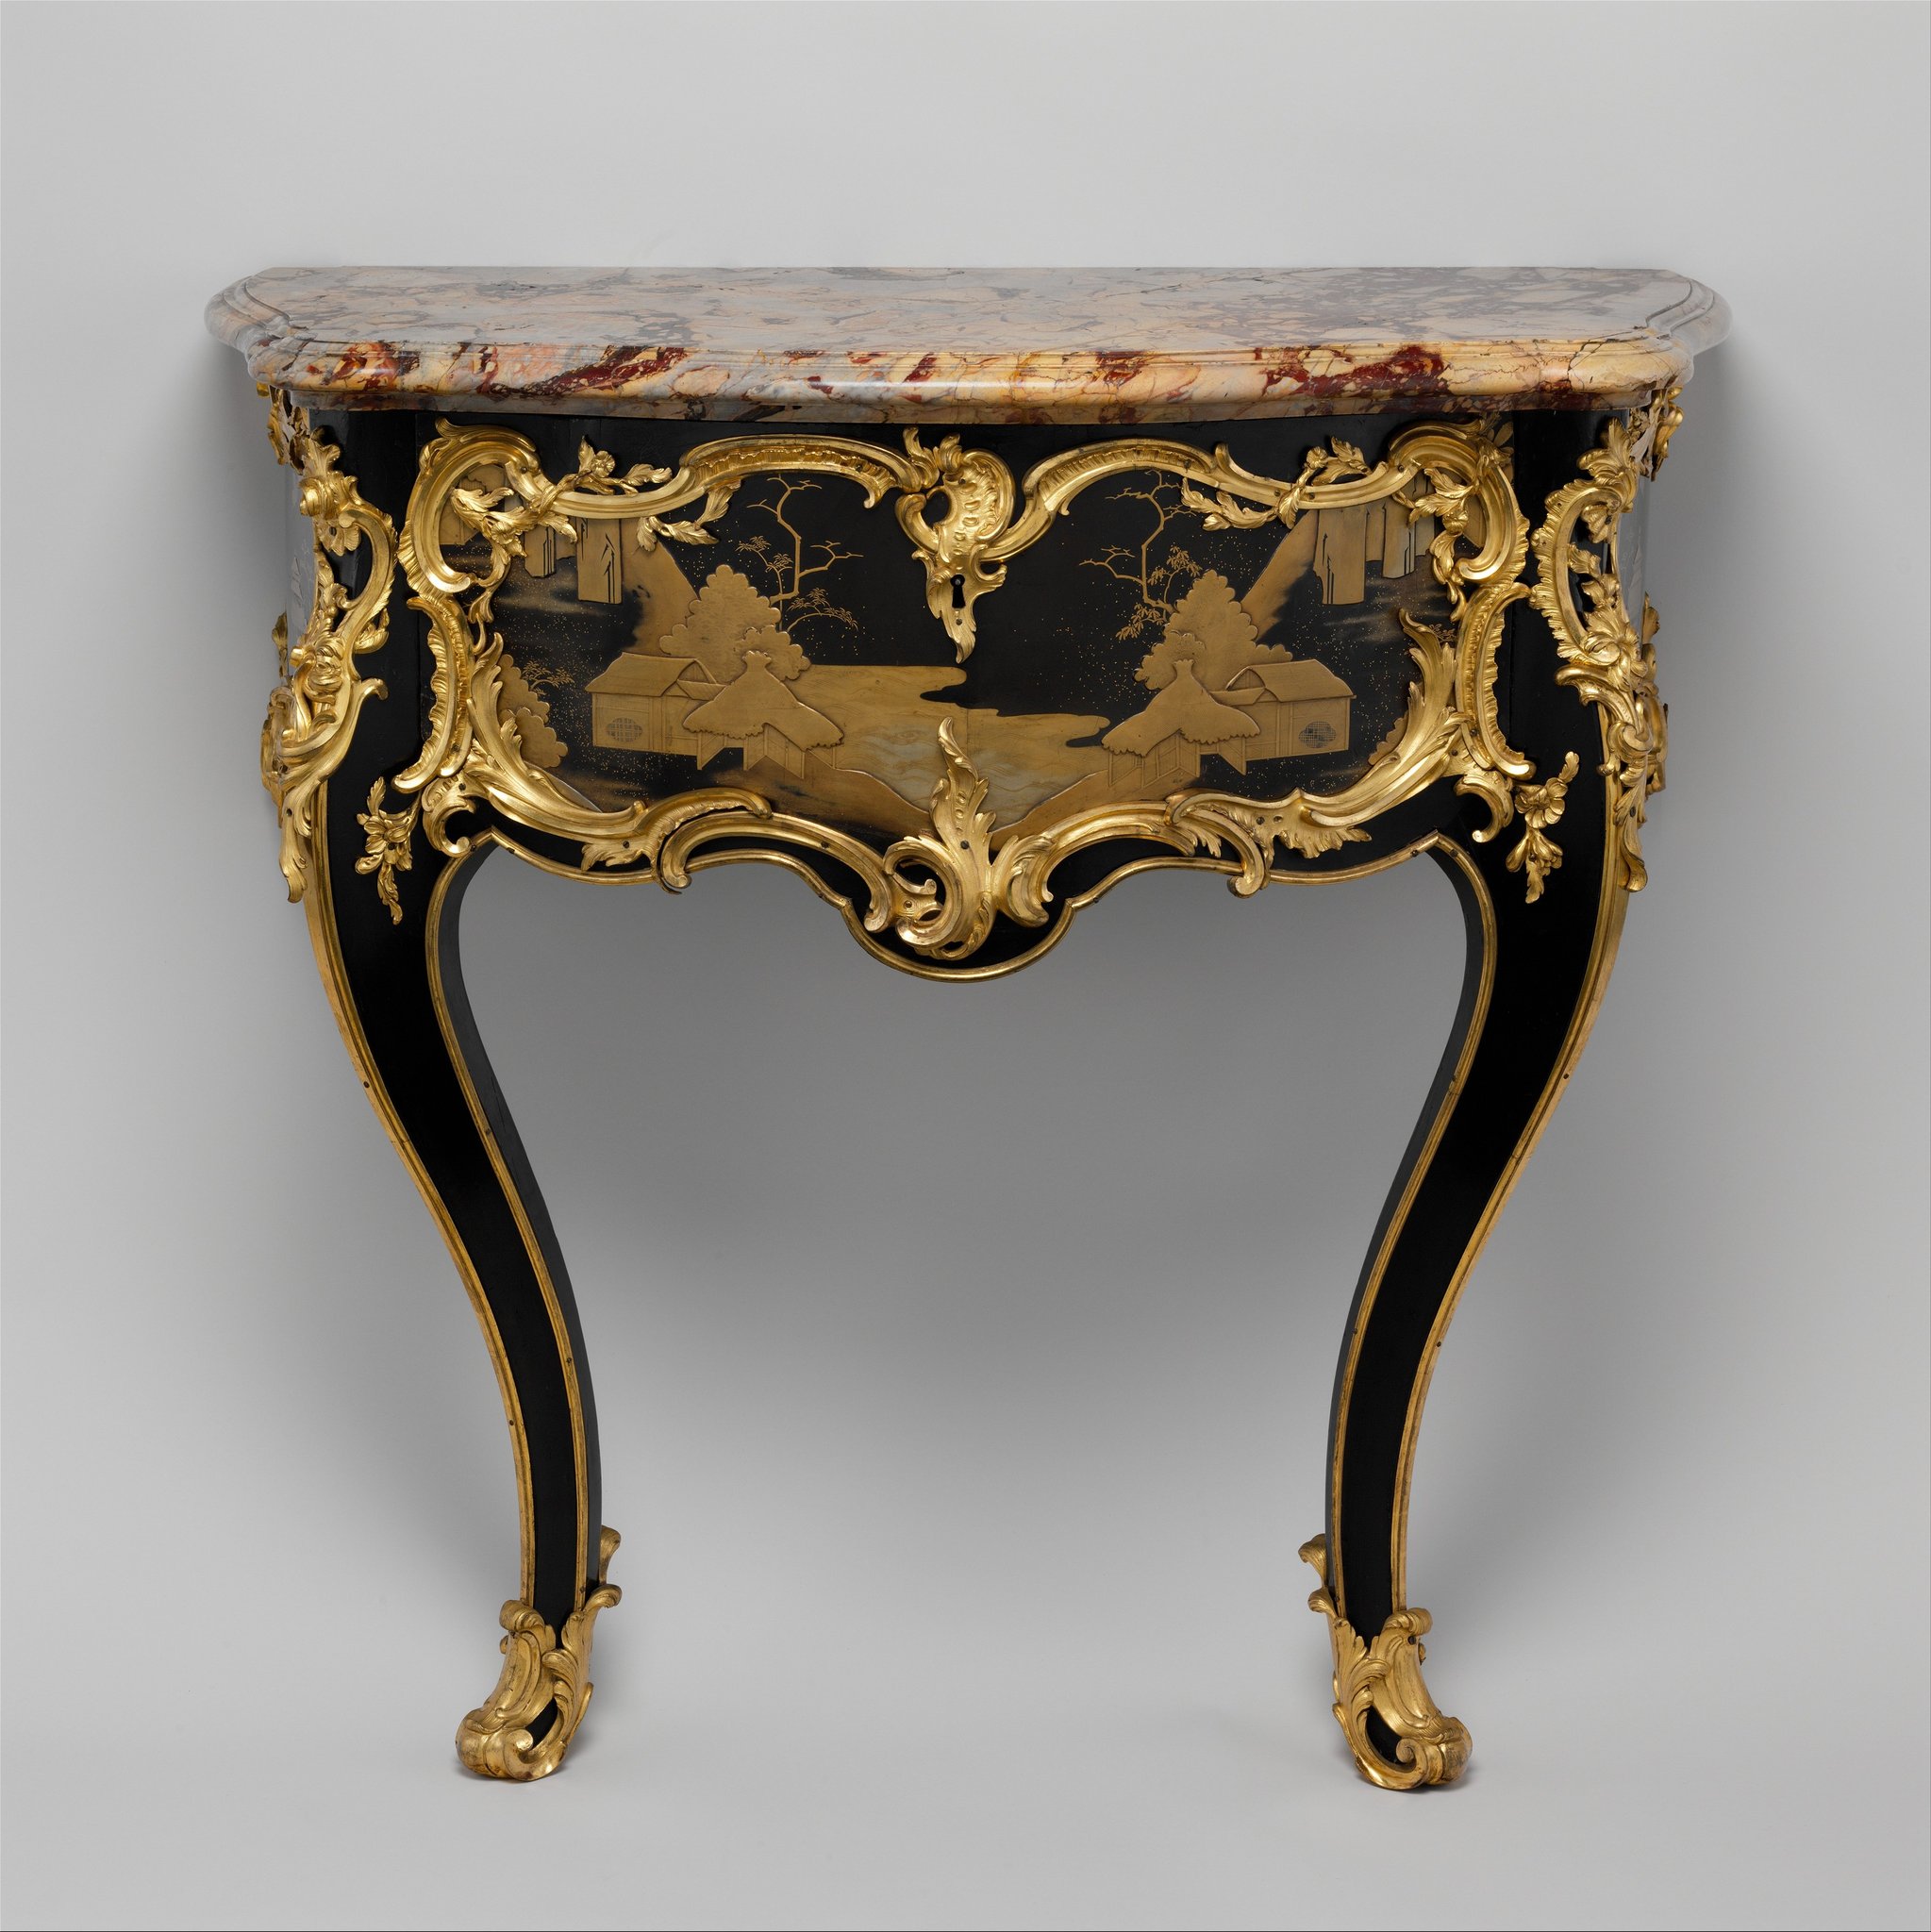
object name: side table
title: Side table (commode en console)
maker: bernard ii van risenburgh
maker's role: maker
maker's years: 1696-1767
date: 1755-1760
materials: gilt bronze, gold, lacquer, marble, wood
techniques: lacquer, veneering